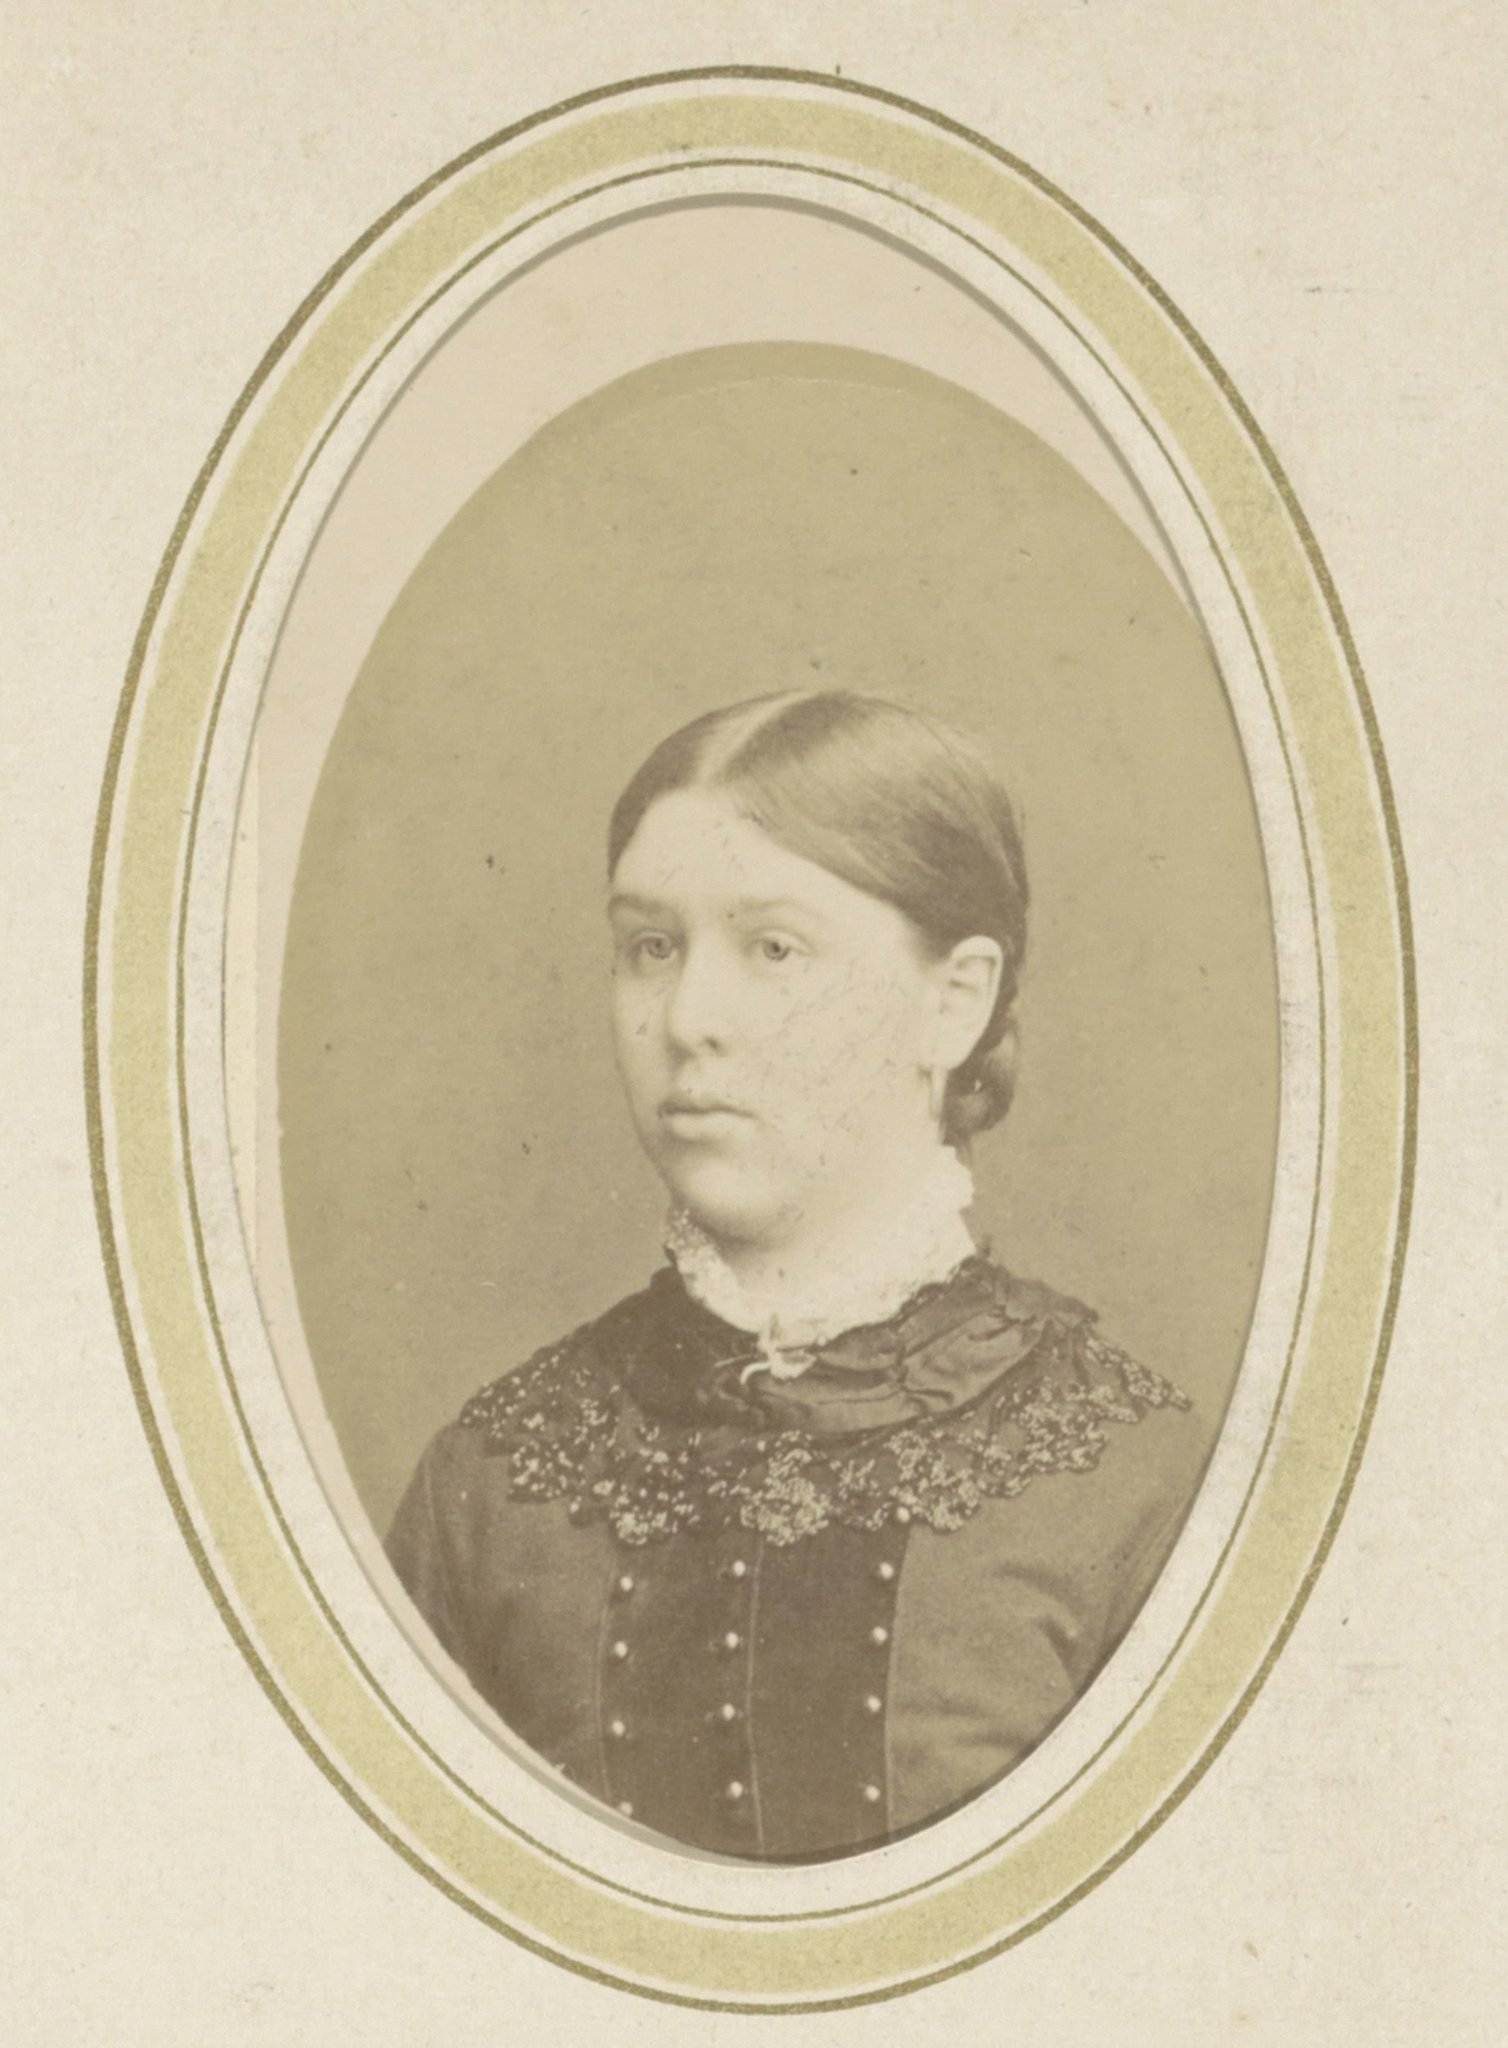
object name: photograph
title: Portret van een jonge vrouw met een versierde kraag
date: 1881-1900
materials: cardboard, paper, photographic support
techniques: albumen print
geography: arnhem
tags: historical persons, styles of hairdress - aa - ~ women, clothing for the upper part of the body, neck-gear: collar, arnhem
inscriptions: address: ‘Menthensteeg No. 7 Arnhem’, address: ‘Arnhem’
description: Onderdeel van Fotoalbum van een Nederlandse familie met 168 cartes-de-visite en kabinetfoto's.